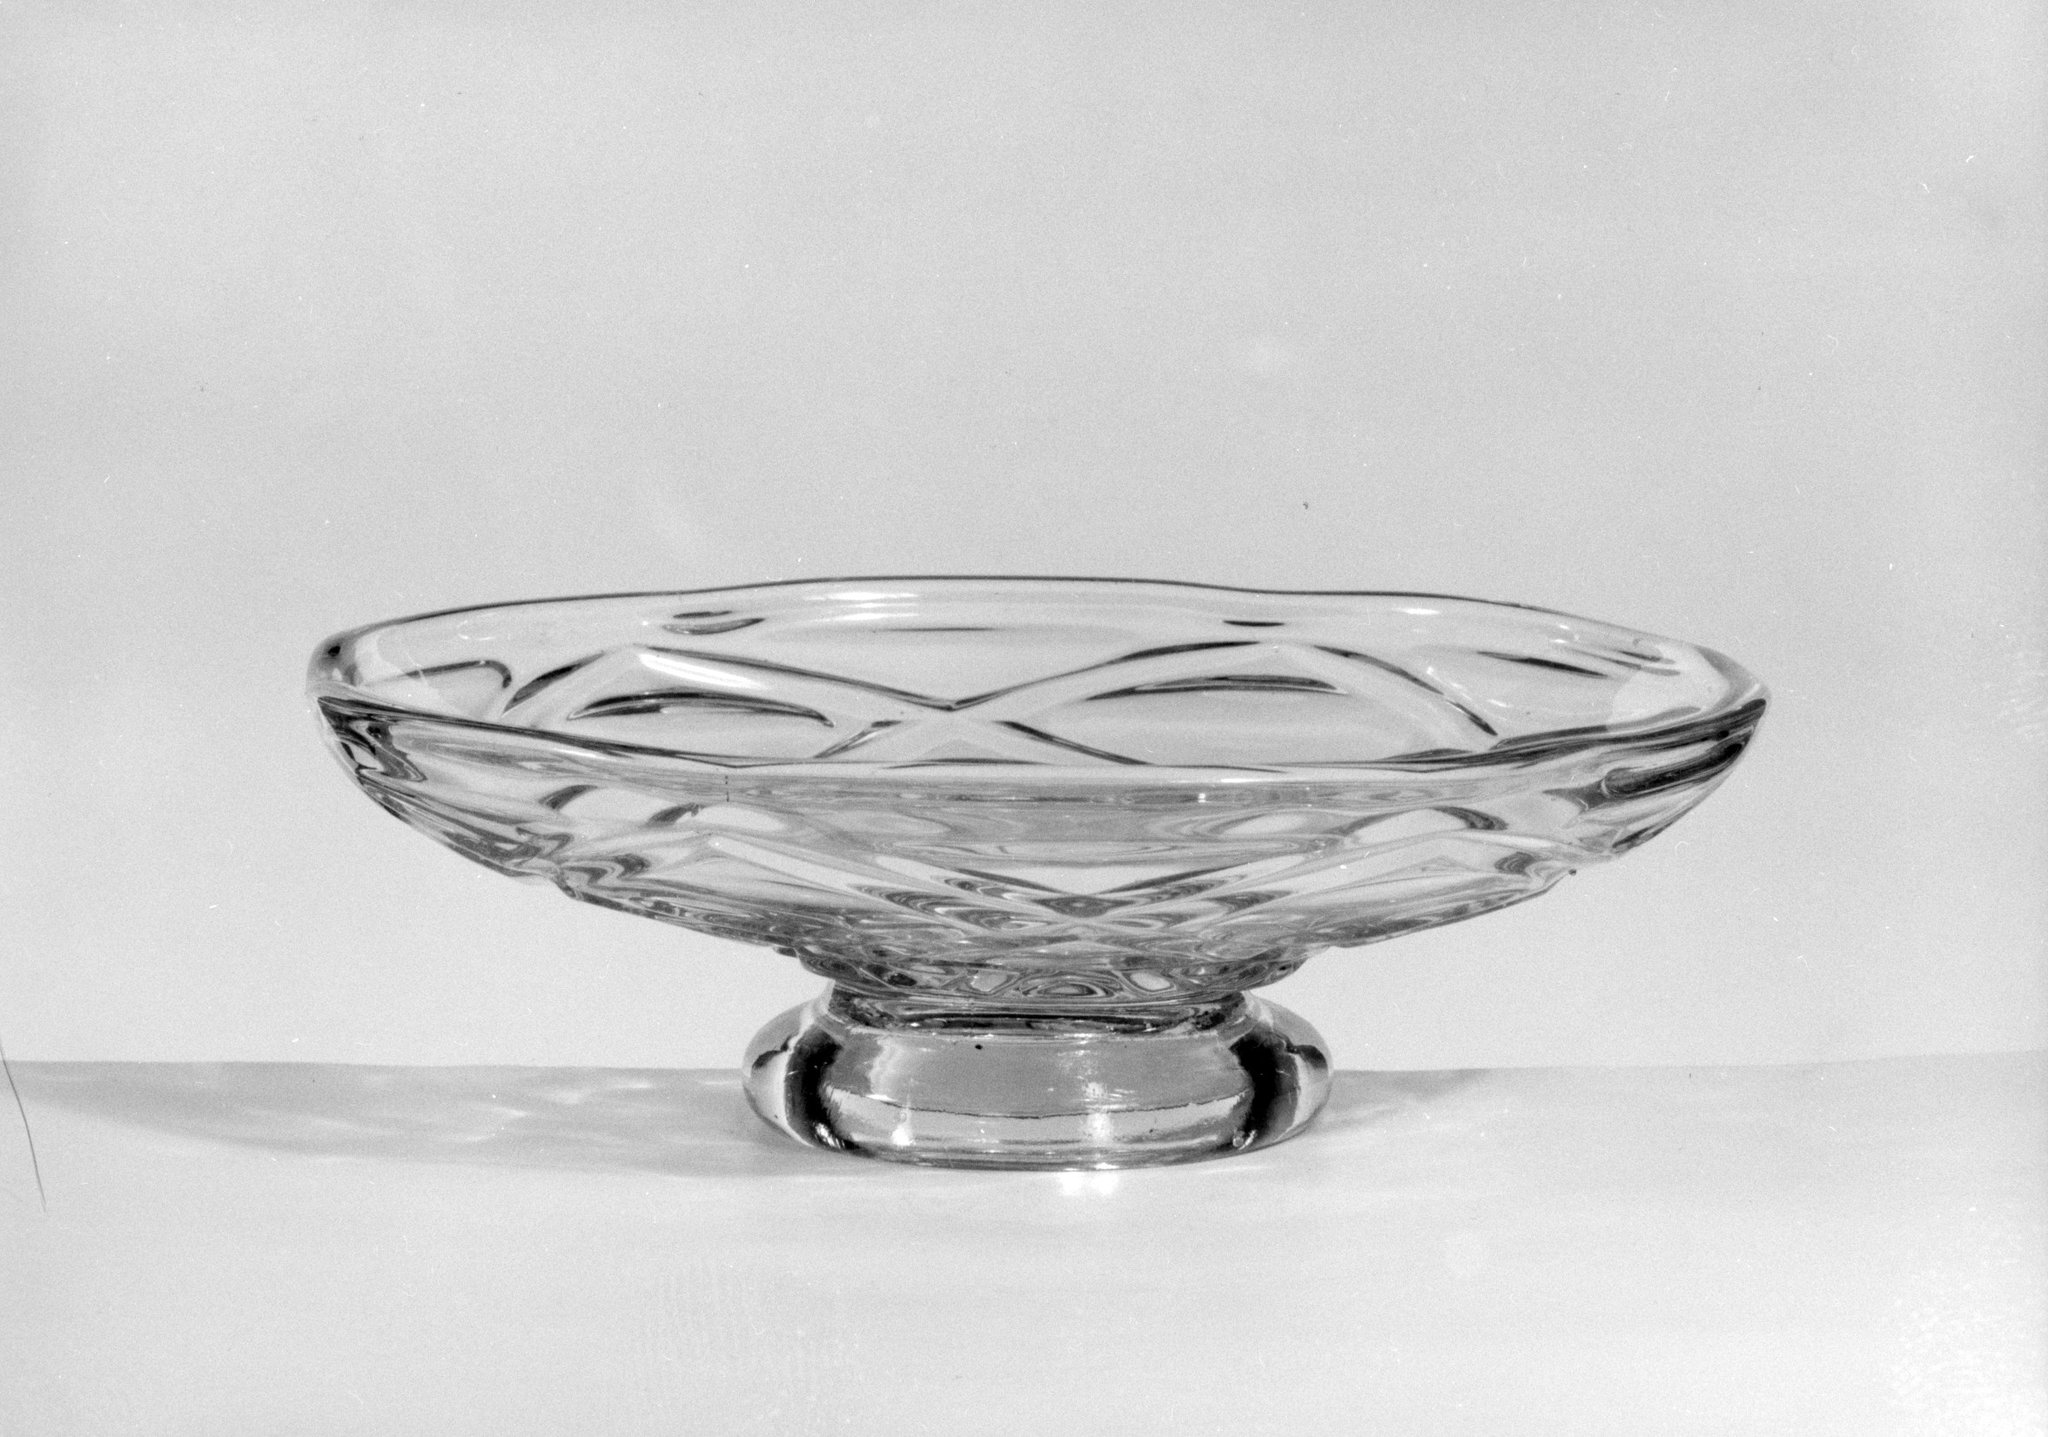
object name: compote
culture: american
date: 1850-1860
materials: diamond, glass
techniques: pressed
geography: united states